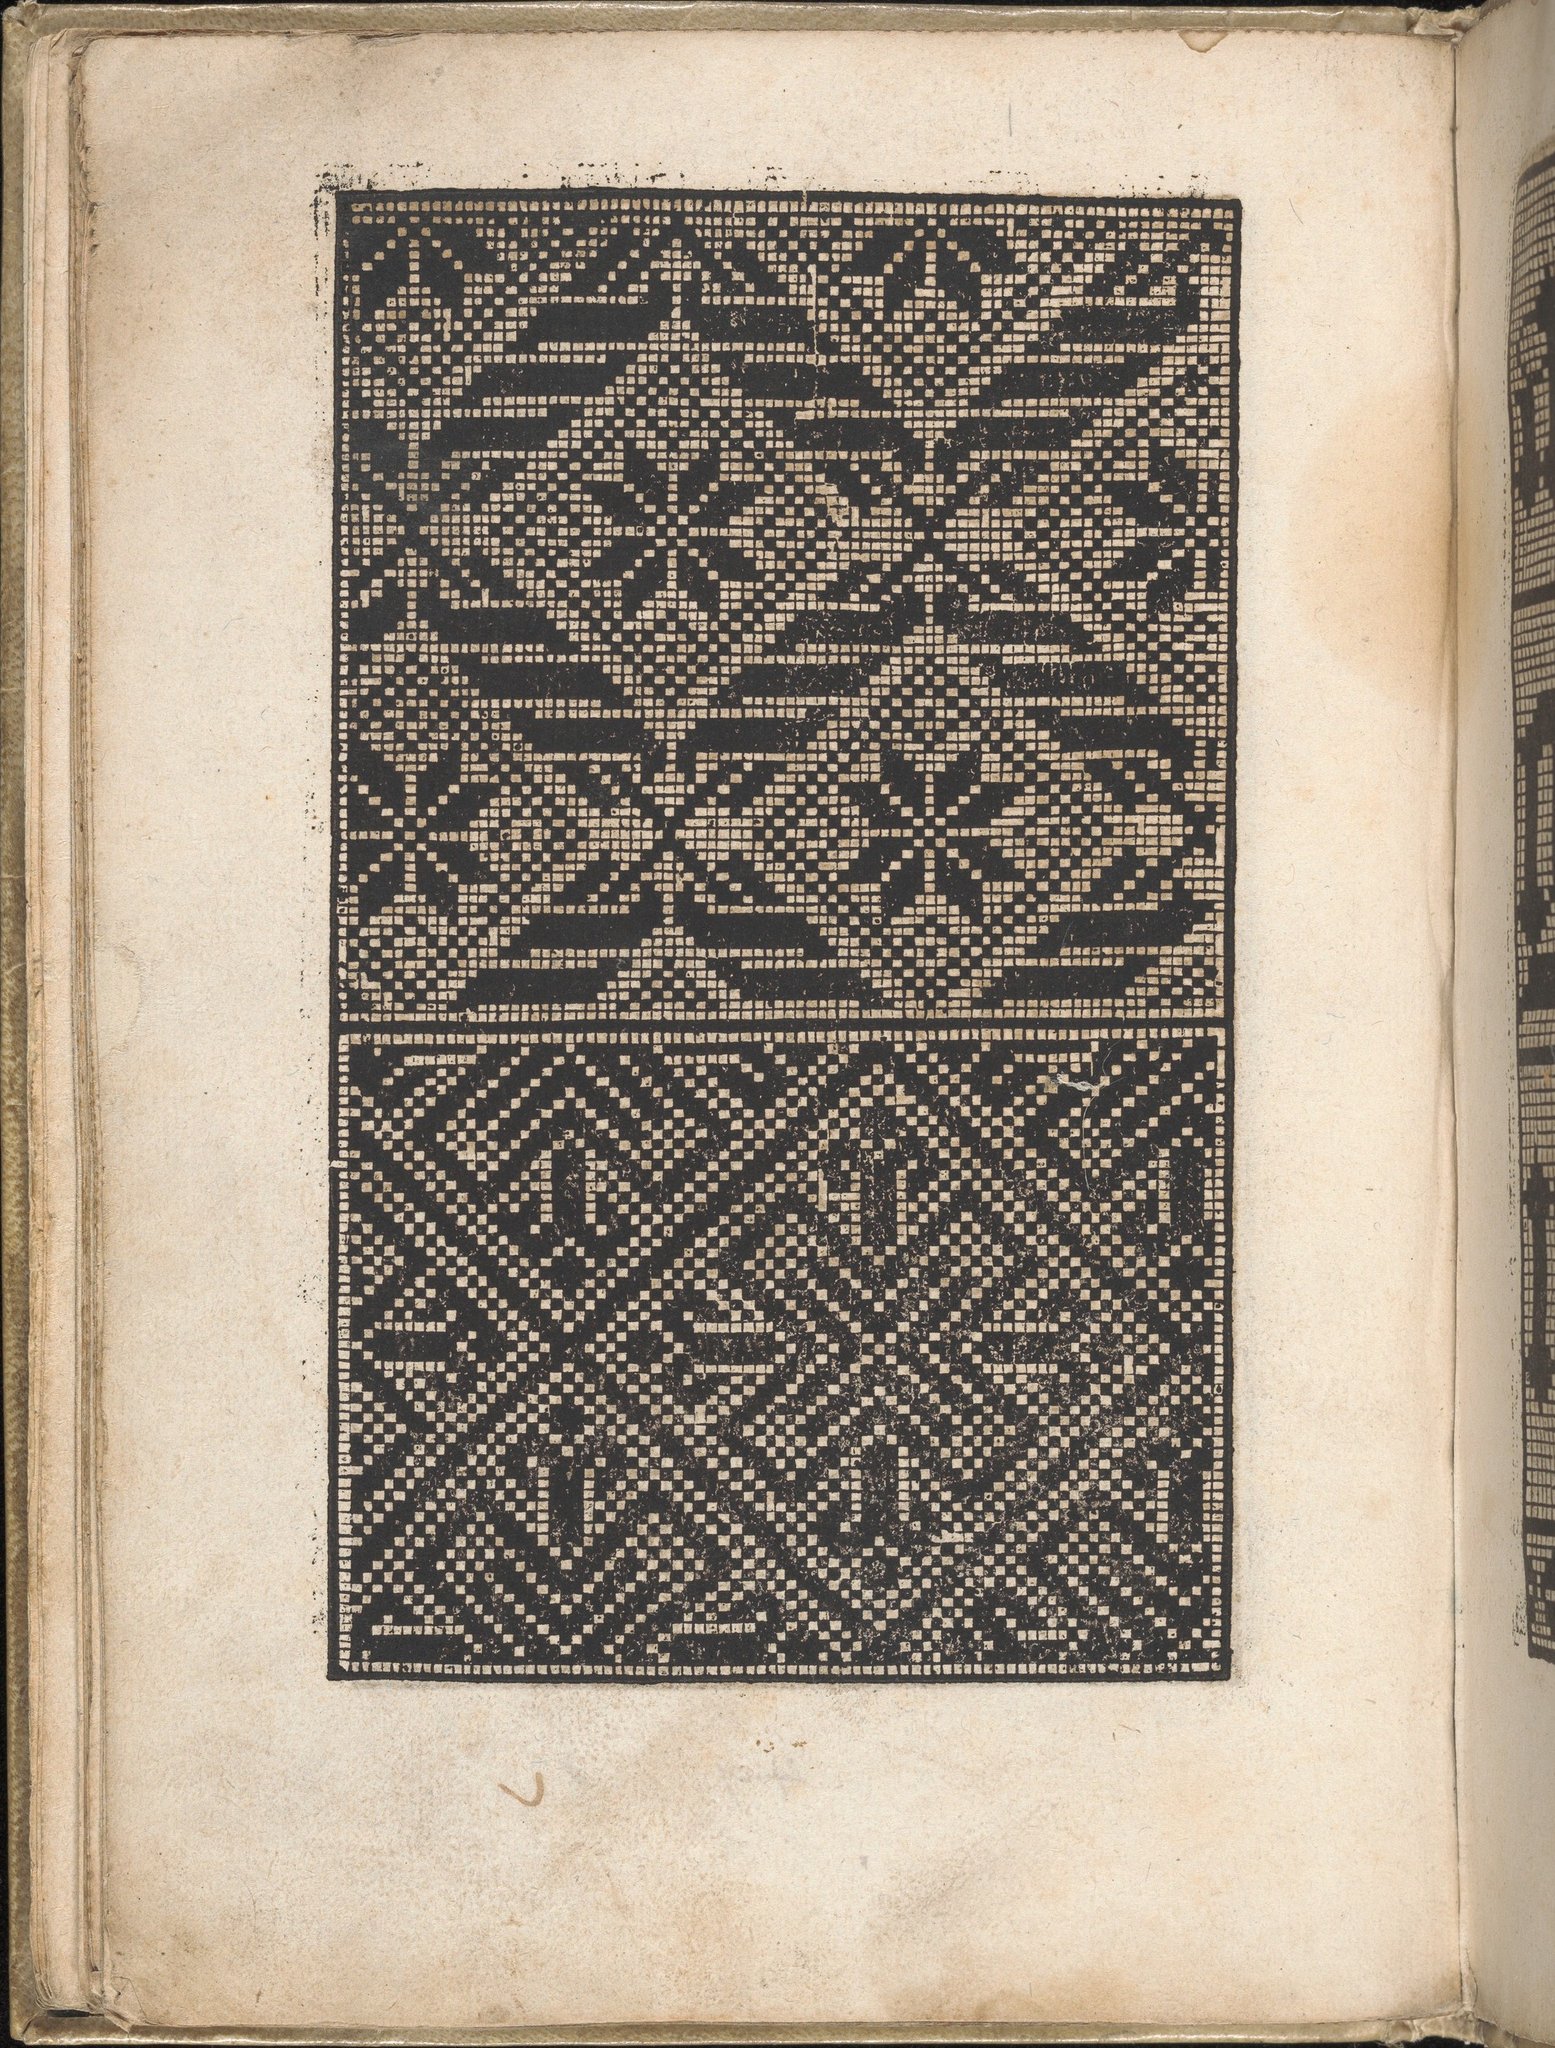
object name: book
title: Page 23v, from "Eyn New Kunstlichboich"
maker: peter quentel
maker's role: publisher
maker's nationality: german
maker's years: 1500-1550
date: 1529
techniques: woodcut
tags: flowers